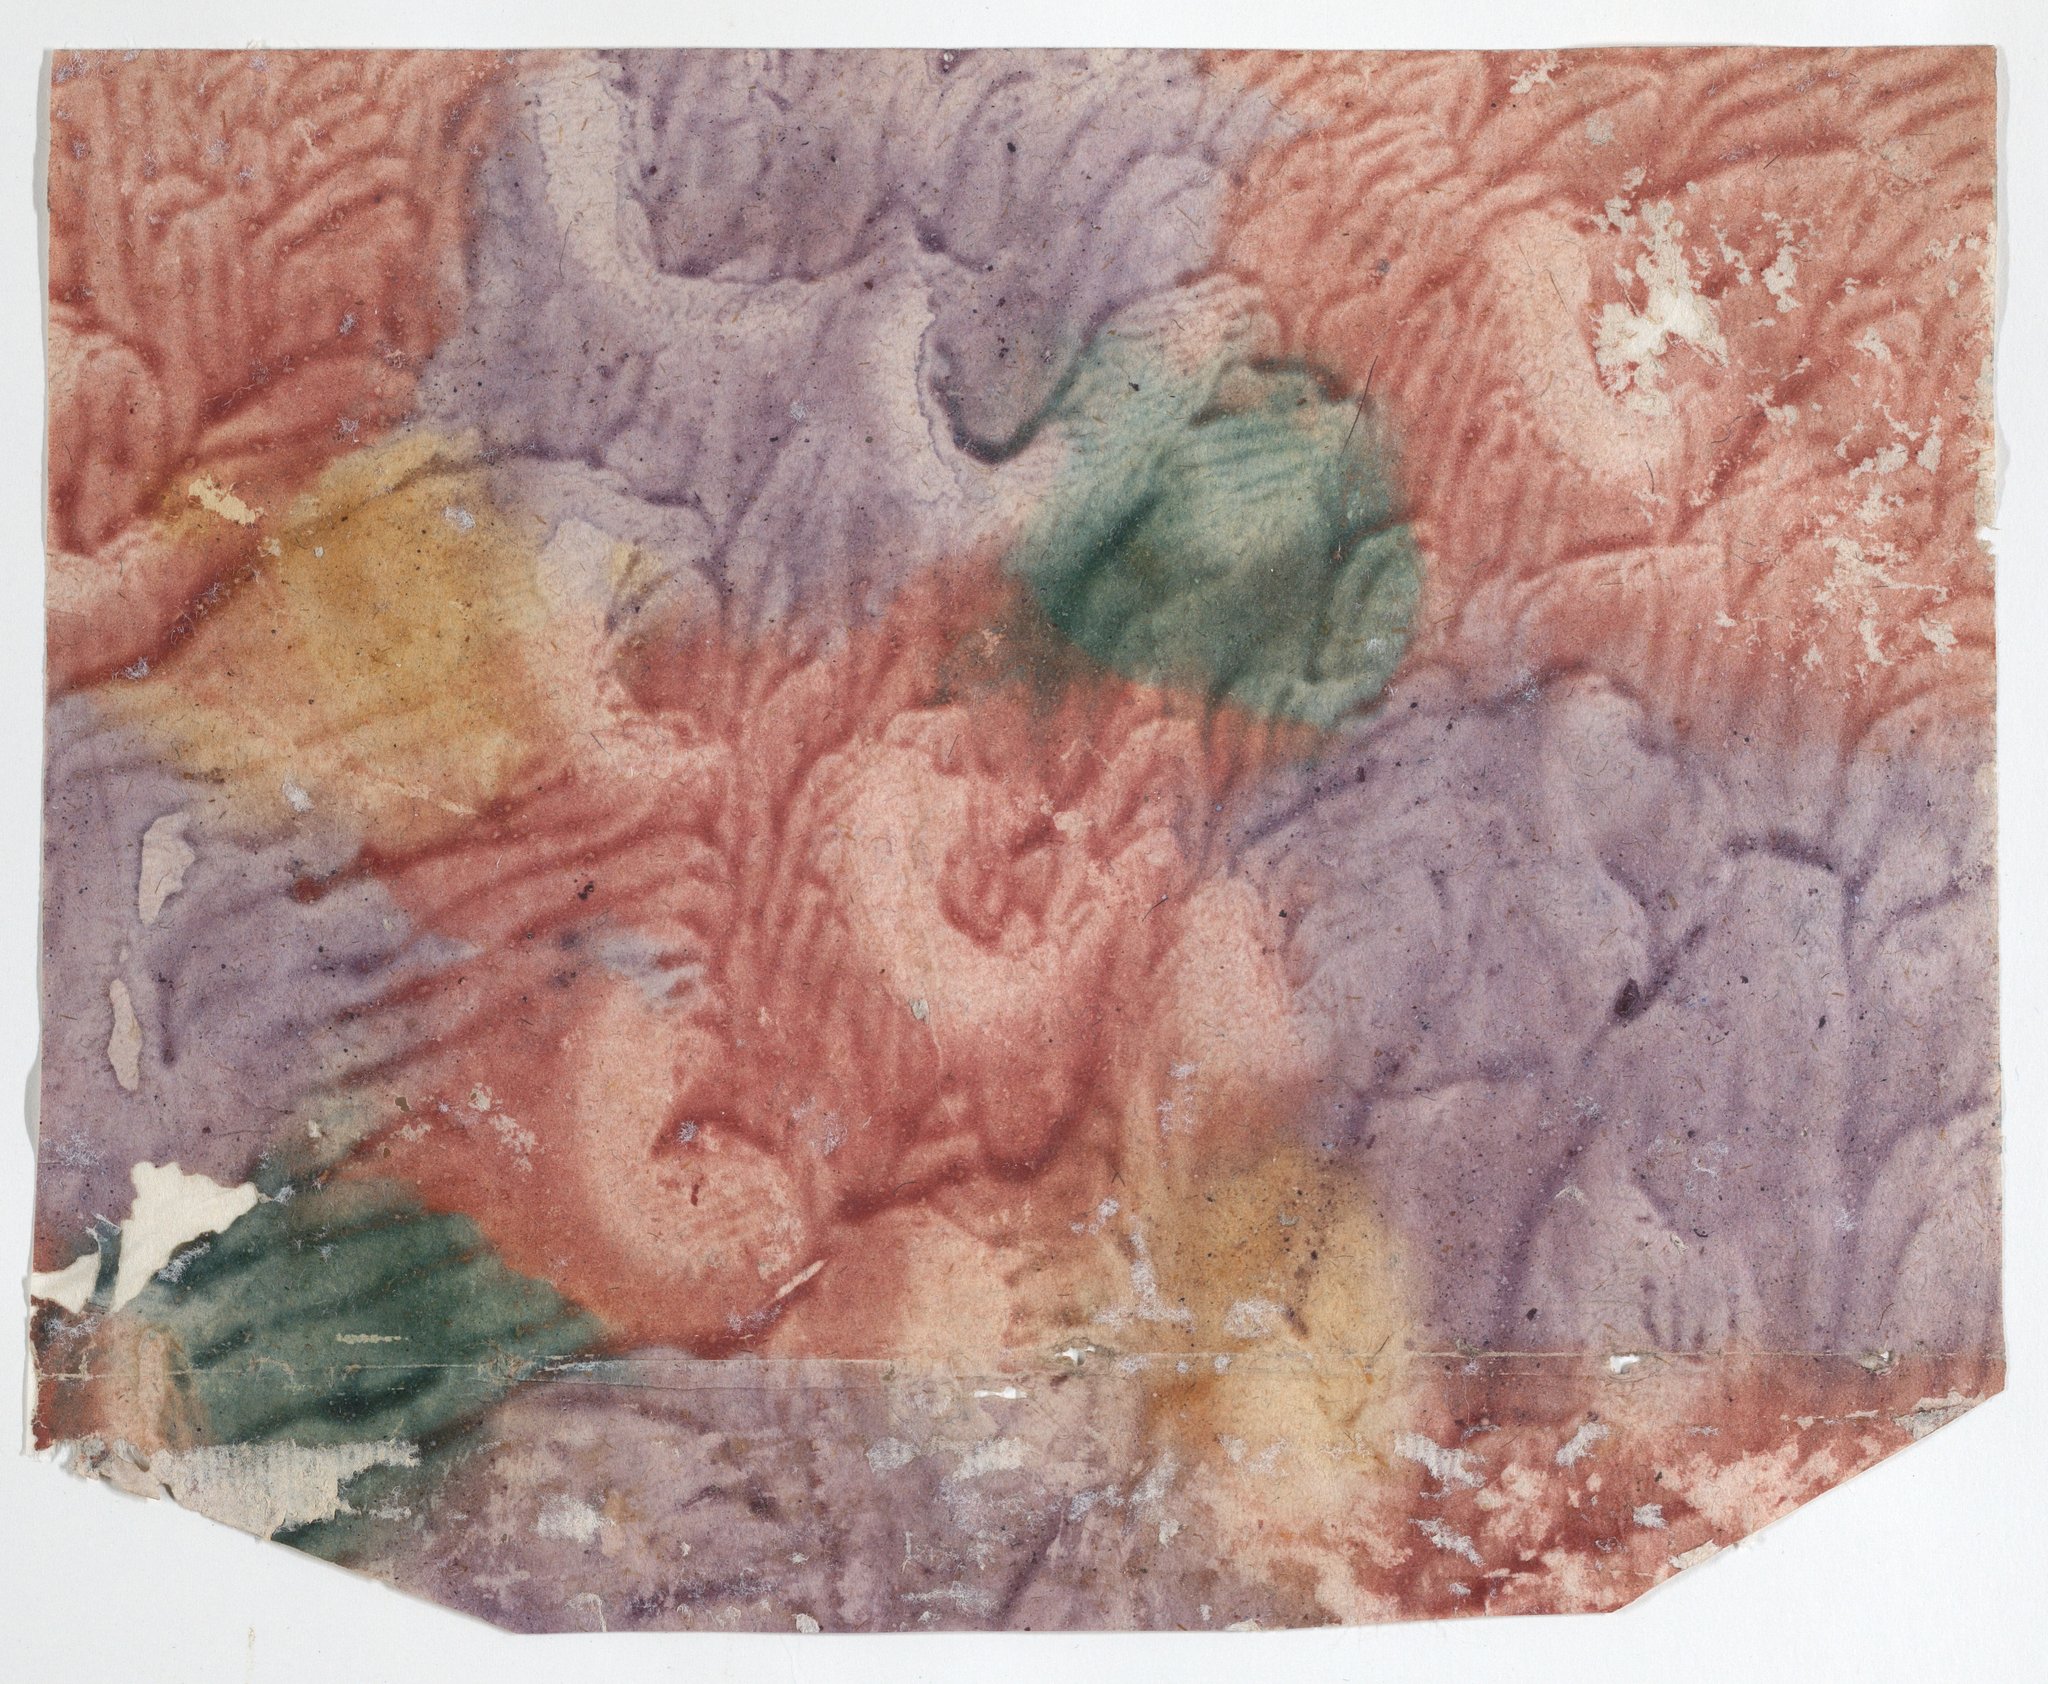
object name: print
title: Paste paper with red, purple, yellow, and green design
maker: Anonymous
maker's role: artist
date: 1701-1800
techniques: relief print